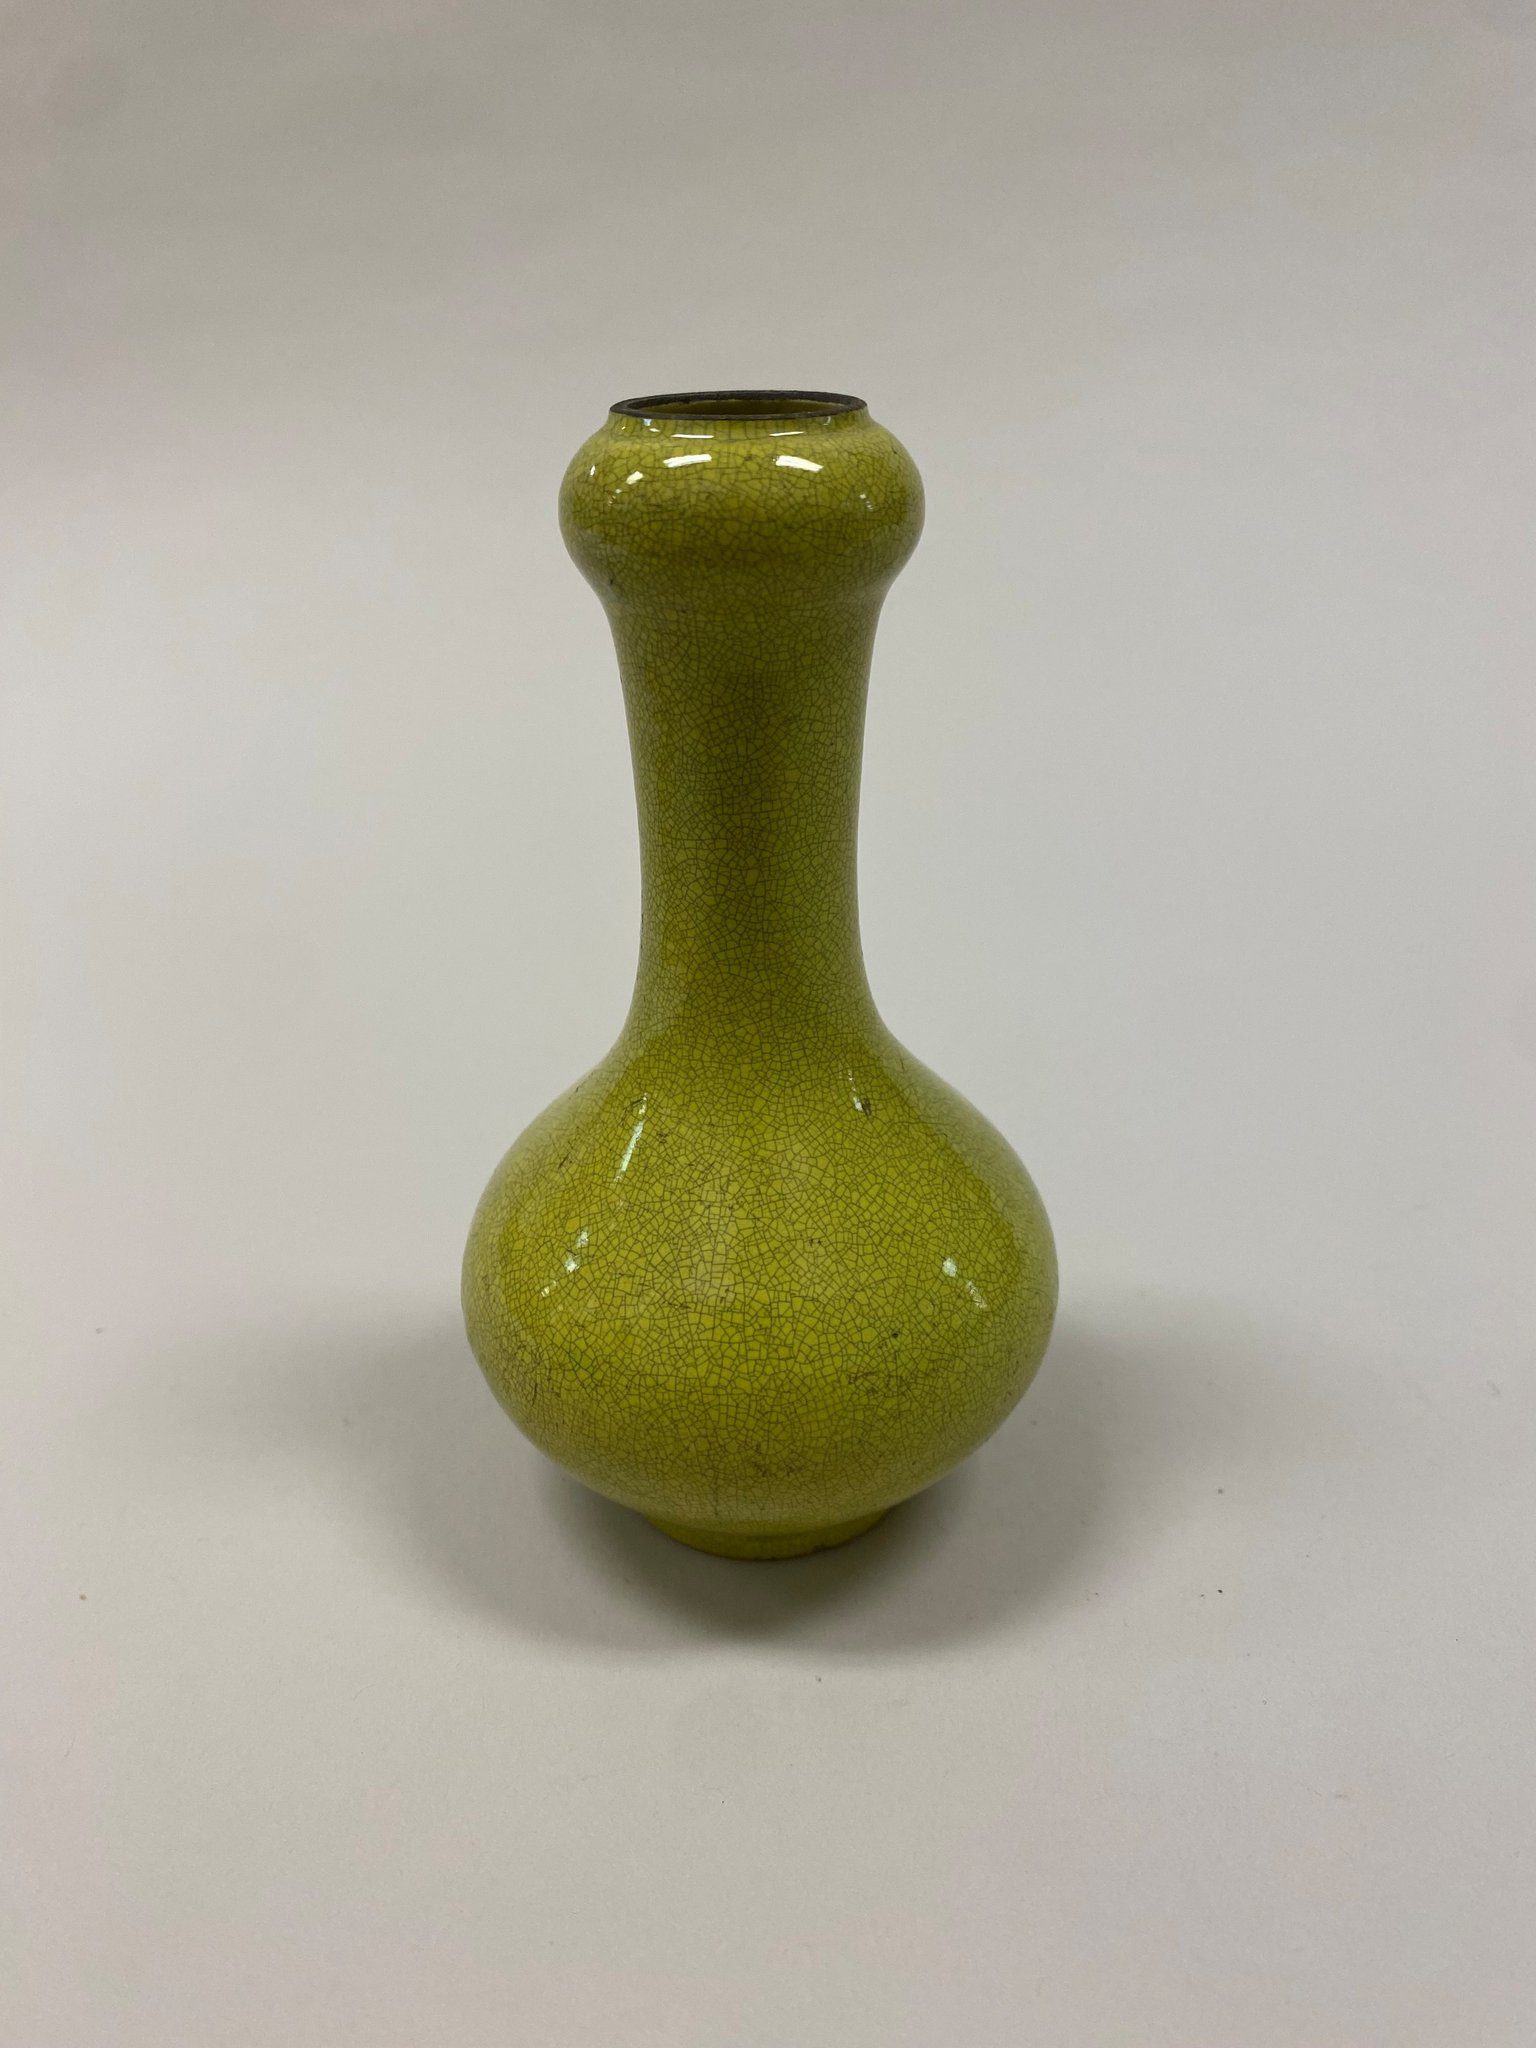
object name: vase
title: Bottle vase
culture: chinese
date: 1701-1800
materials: glaze, porcelain